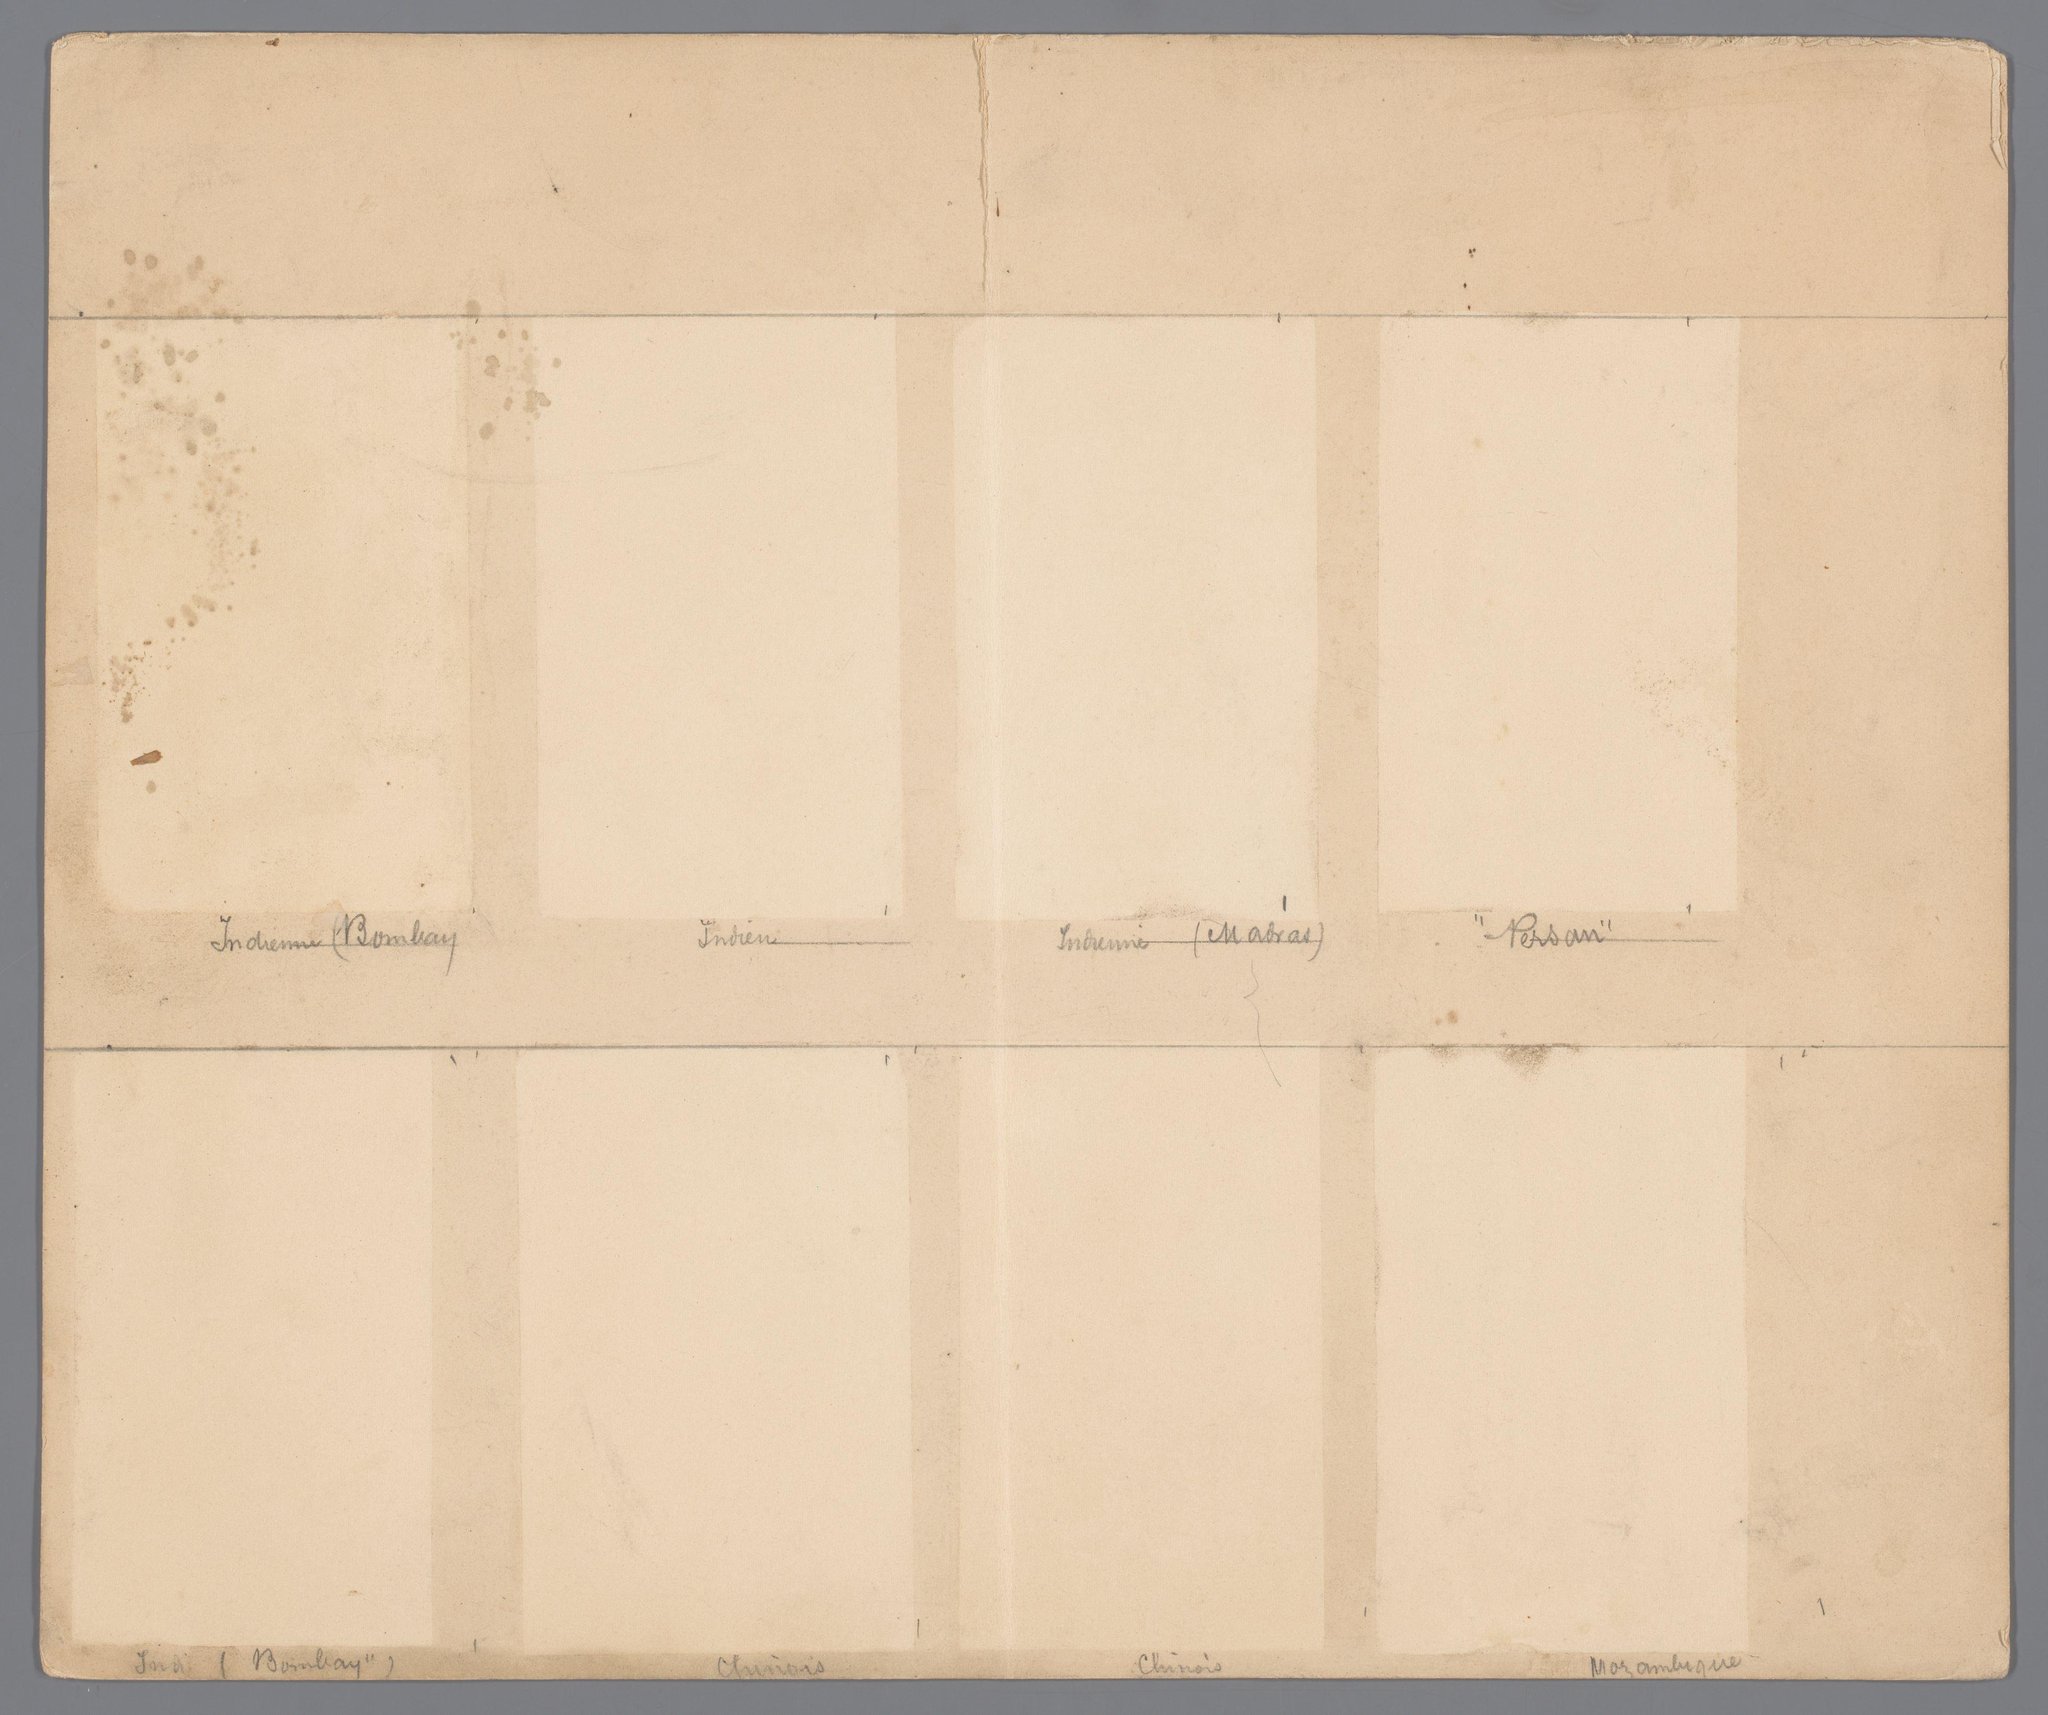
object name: album leaf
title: Albumblad zonder foto's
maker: s. moro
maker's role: fotograaf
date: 1875-1915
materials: cardboard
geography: mauritius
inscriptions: stamp: ‘S. Moro//PHOTOGRAPHE//MAURICE’, inscription: ‘Md. de Lait Indien; Mahomélan [?]; Indien; Indienne-Calartha [?]; Mozambique; Japonais; Indienne & son "houka"; Chinois; Indienne Bombay; Indien; Indienne (madras); "Nessan"; INd(...?) ( Bomapy"); Chinois; Chinois; Mozambique’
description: Leeg albumblad (foto's zijn verwijderd). In totaal 16 foto's ter grootte van carte-de-visite bevonden zich hierop (resp. 8 recto en 8 verso 8). De onderschriften in het Frans in potlood onder elke verdwenen foto verwijzen naar verschillende landen/nationaliteiten van afgebeelde personen en werelddelen.